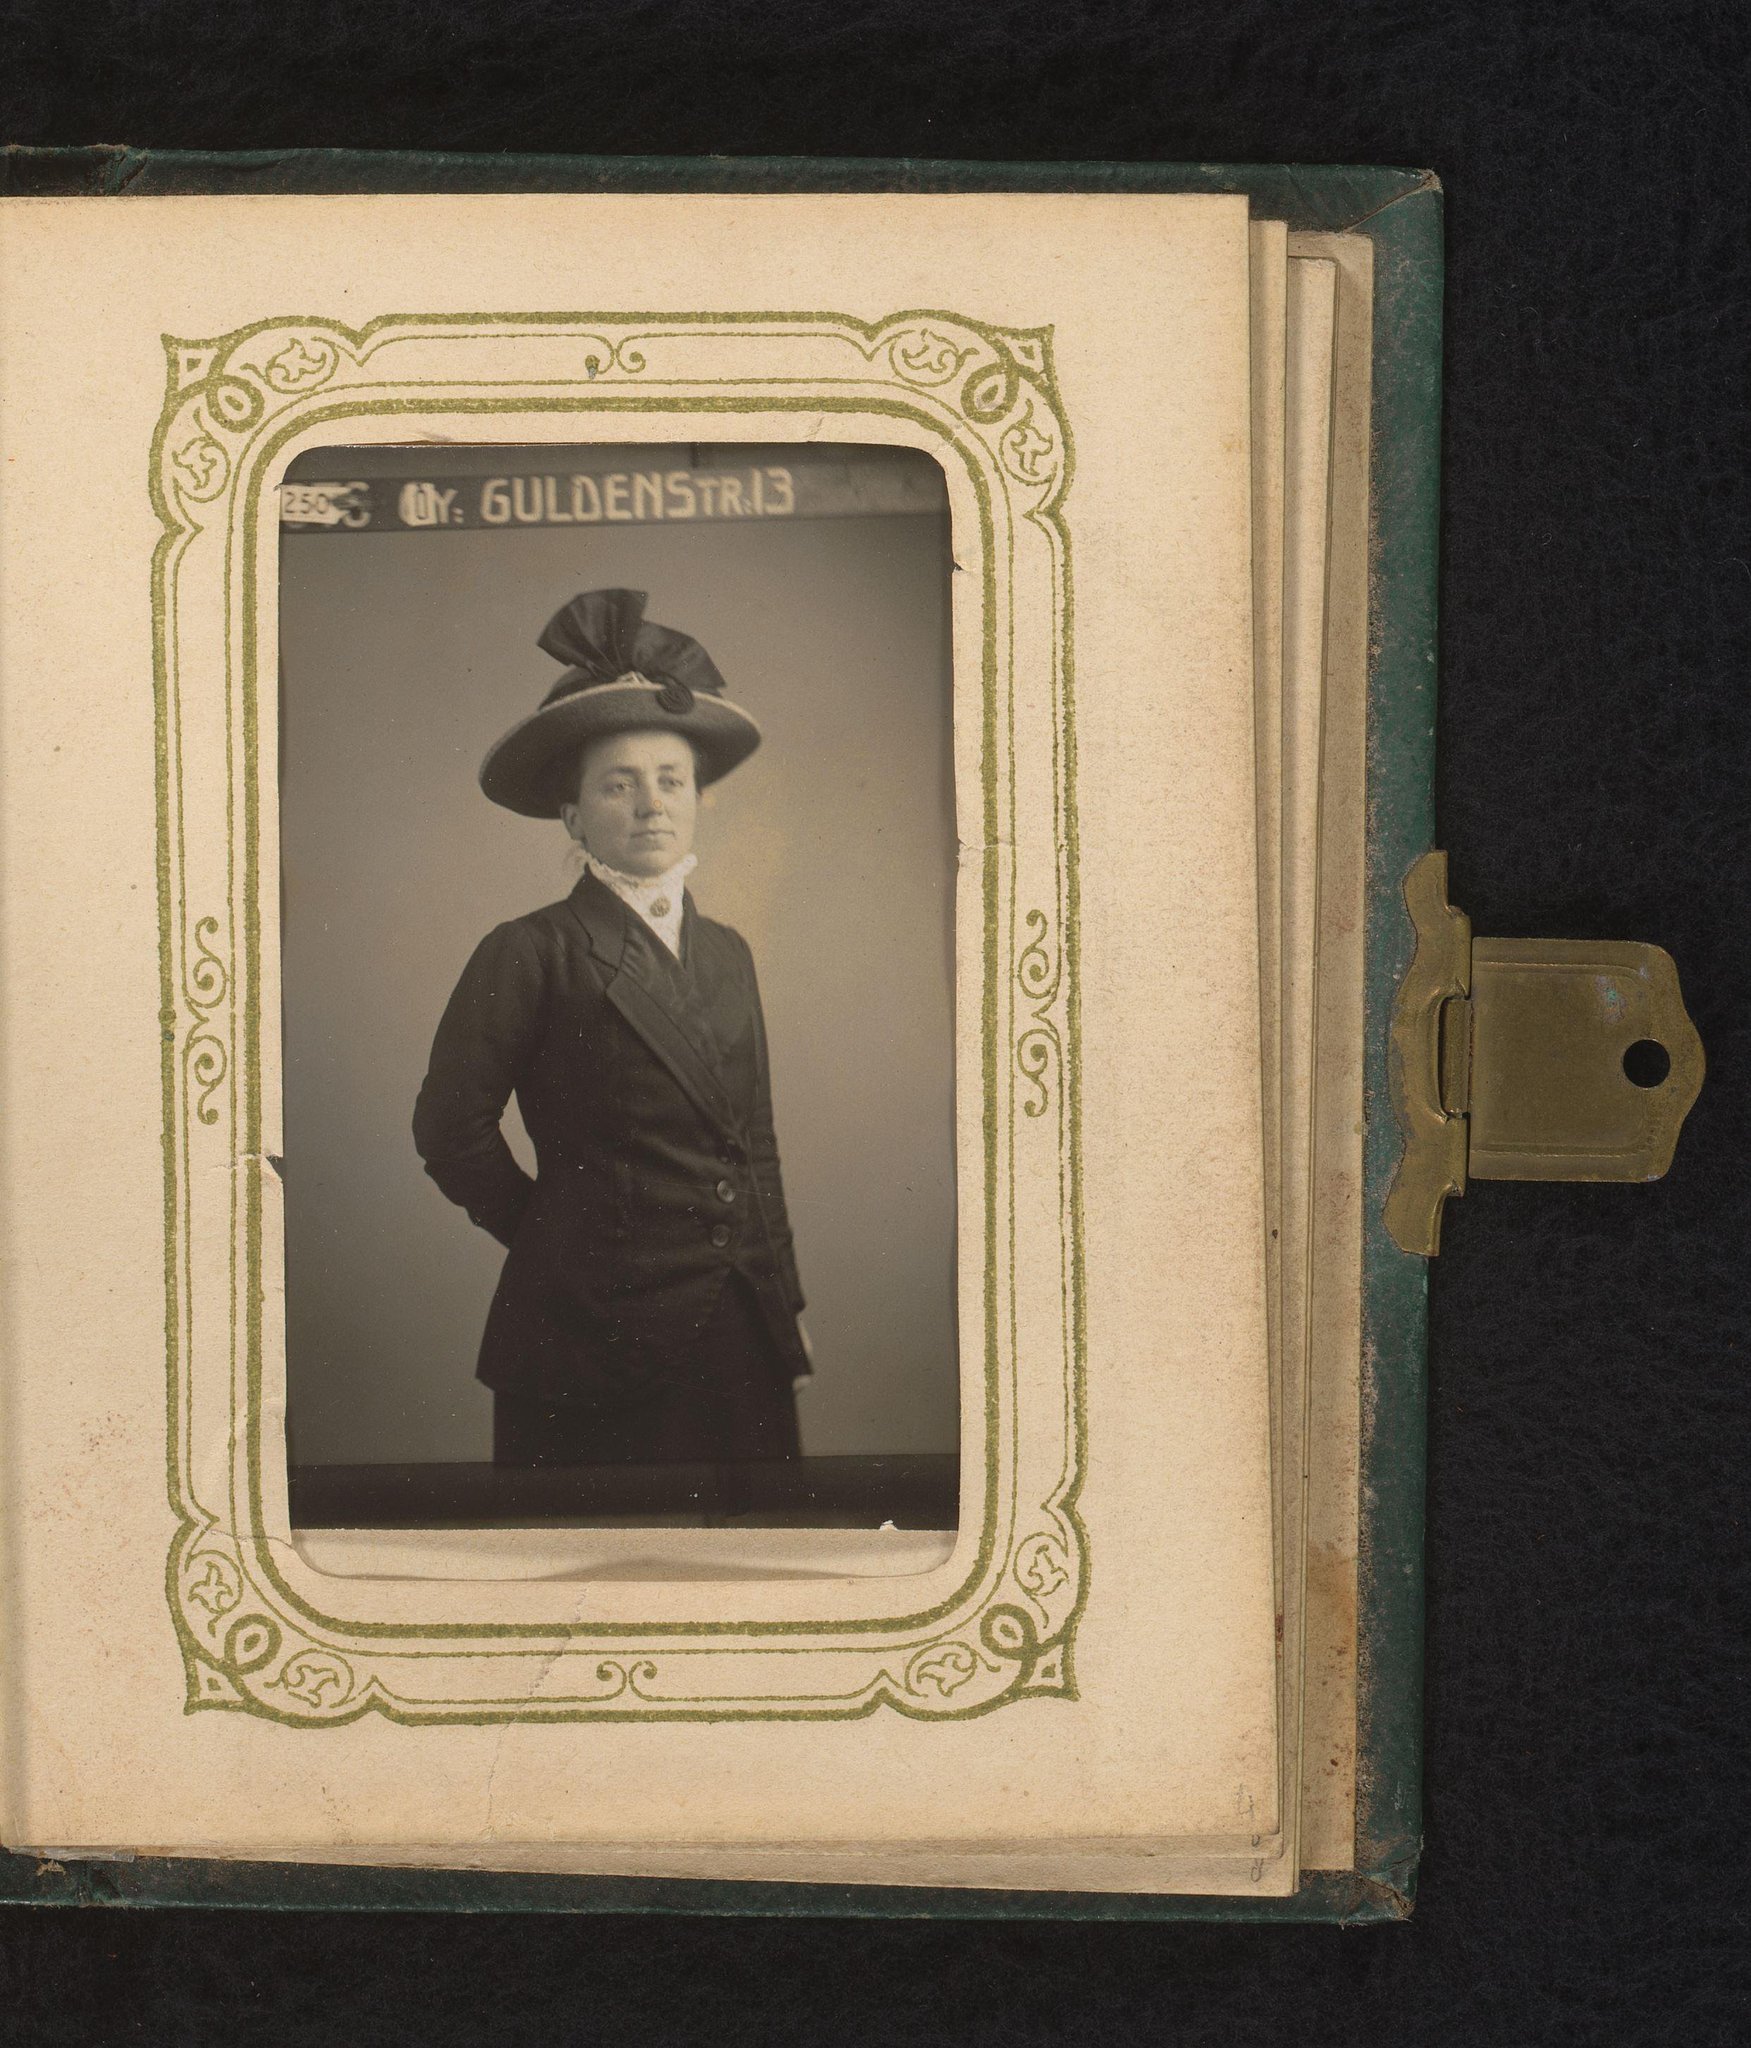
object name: snapshot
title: Portret van een vrouw met hoed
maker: Anonymous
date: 1880-1920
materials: photographic support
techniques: gelatin silver print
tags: adult woman, historical persons, head-gear: hat, standing figure - aa - female human figure